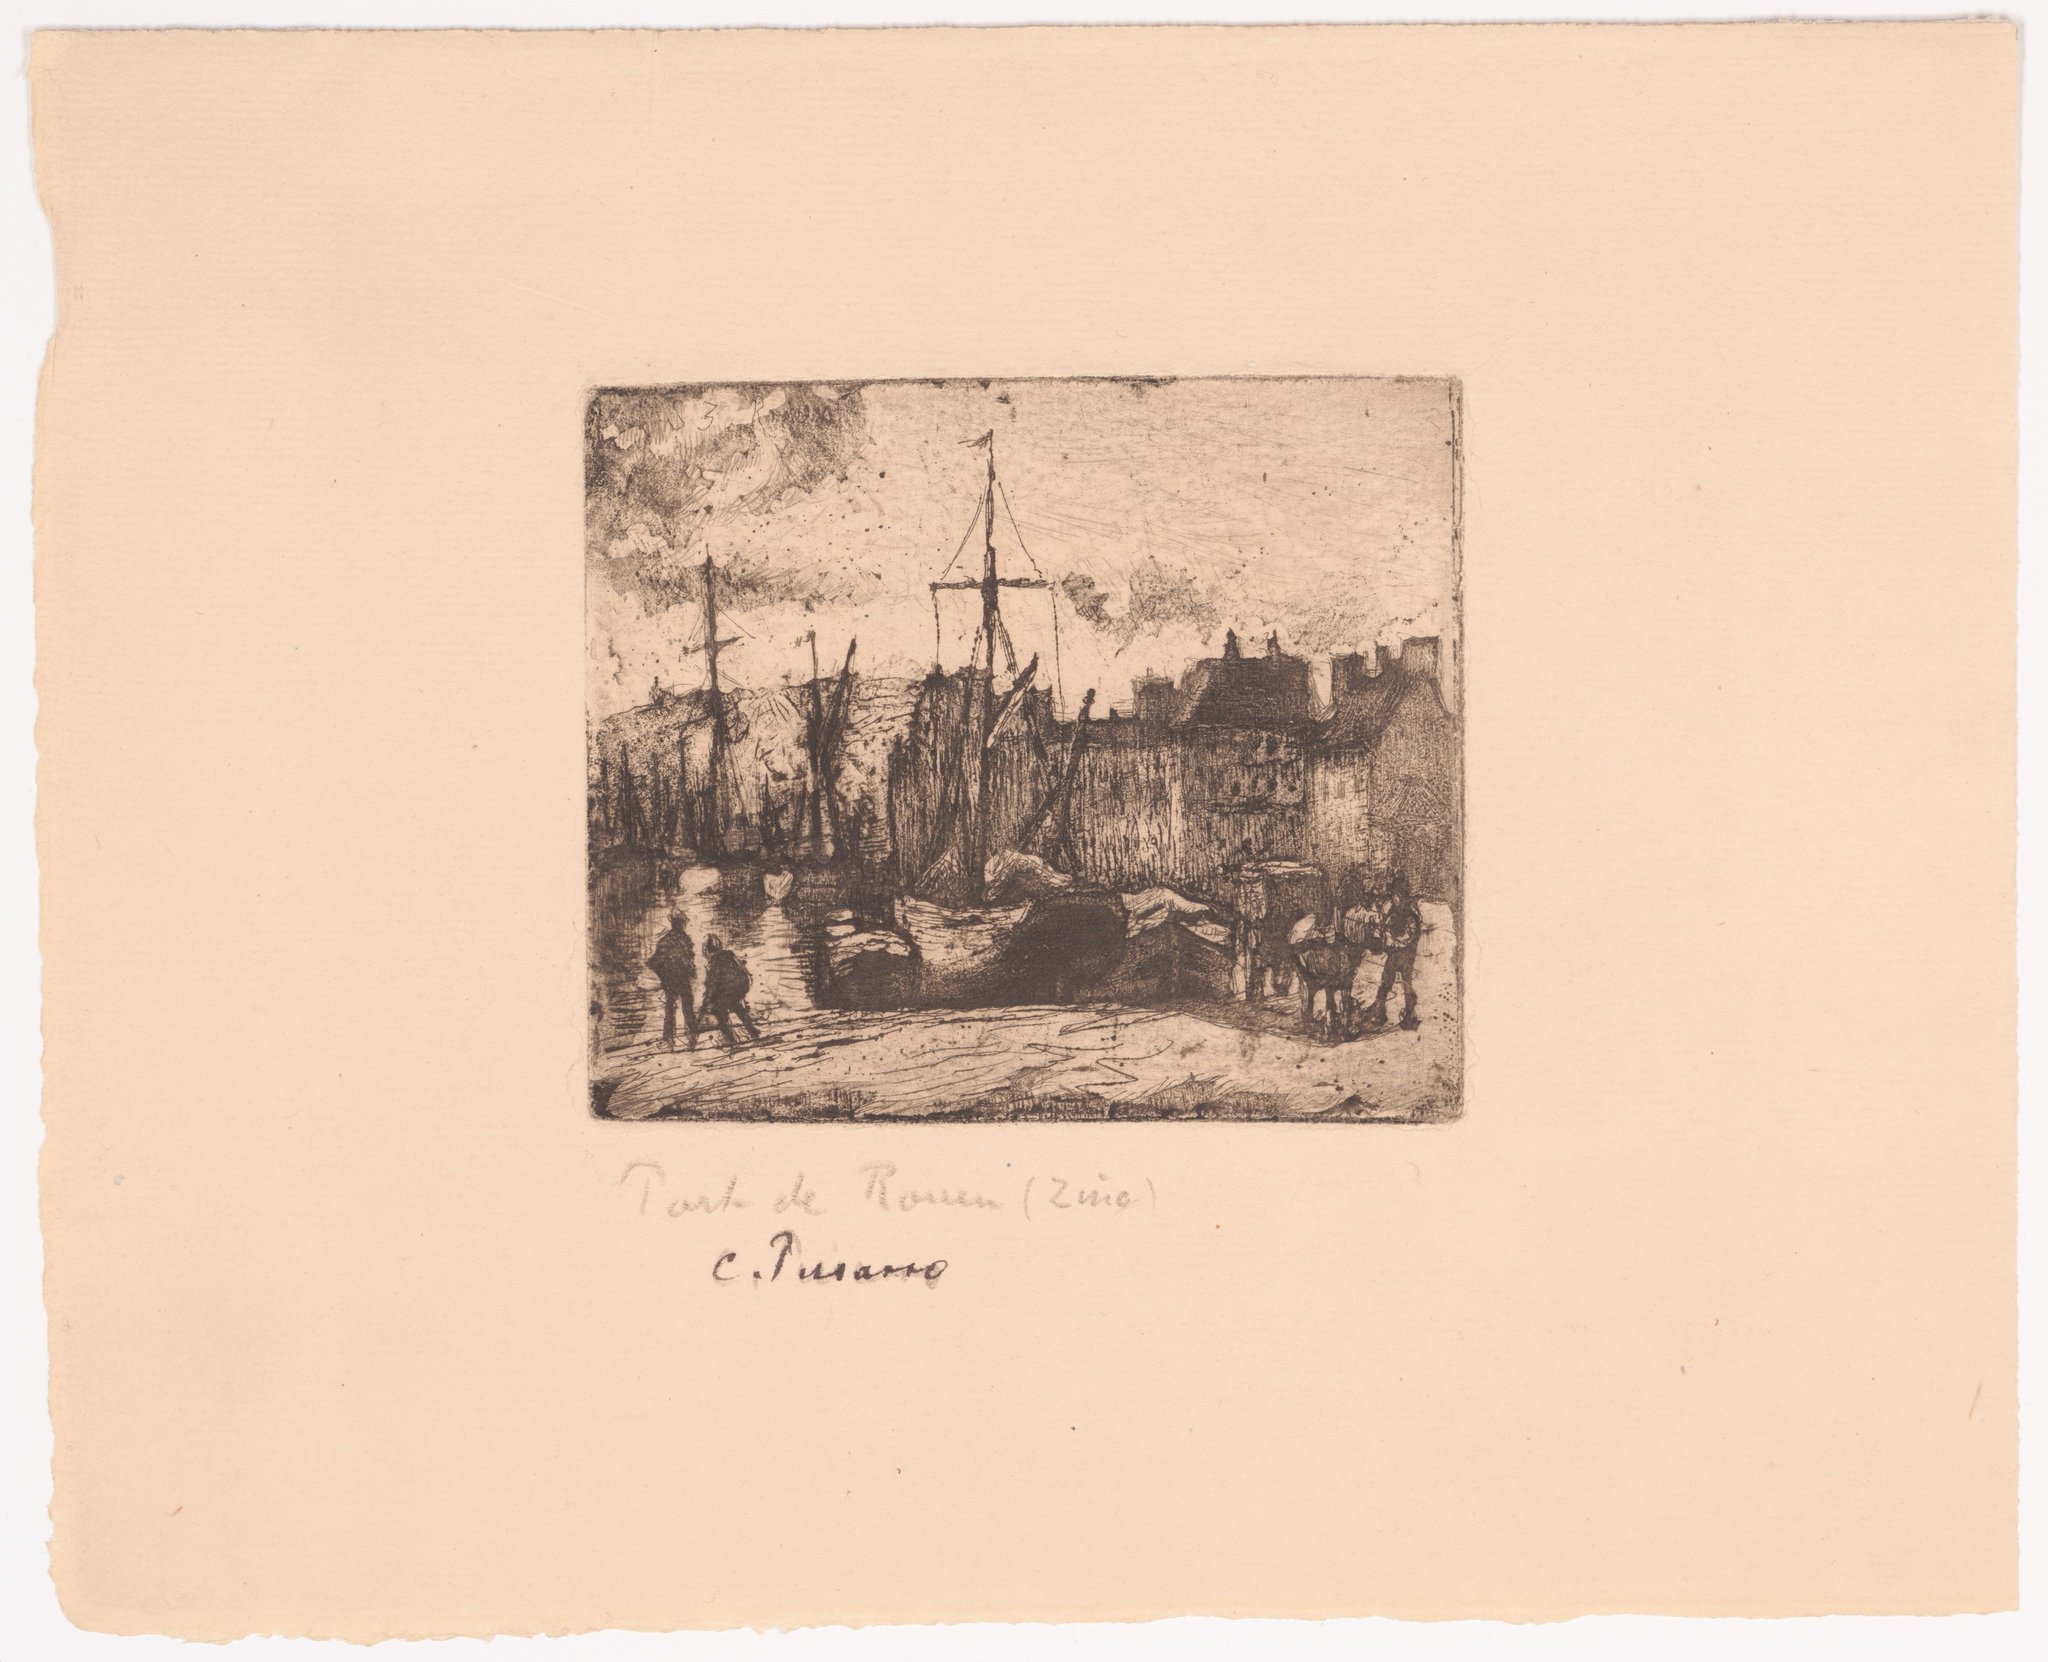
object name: print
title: The Port of Rouen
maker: camille pissarro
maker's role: artist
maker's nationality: french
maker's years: 1830-1903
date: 1885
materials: paper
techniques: aquatint, drypoint, etching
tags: human figures,houses,boats